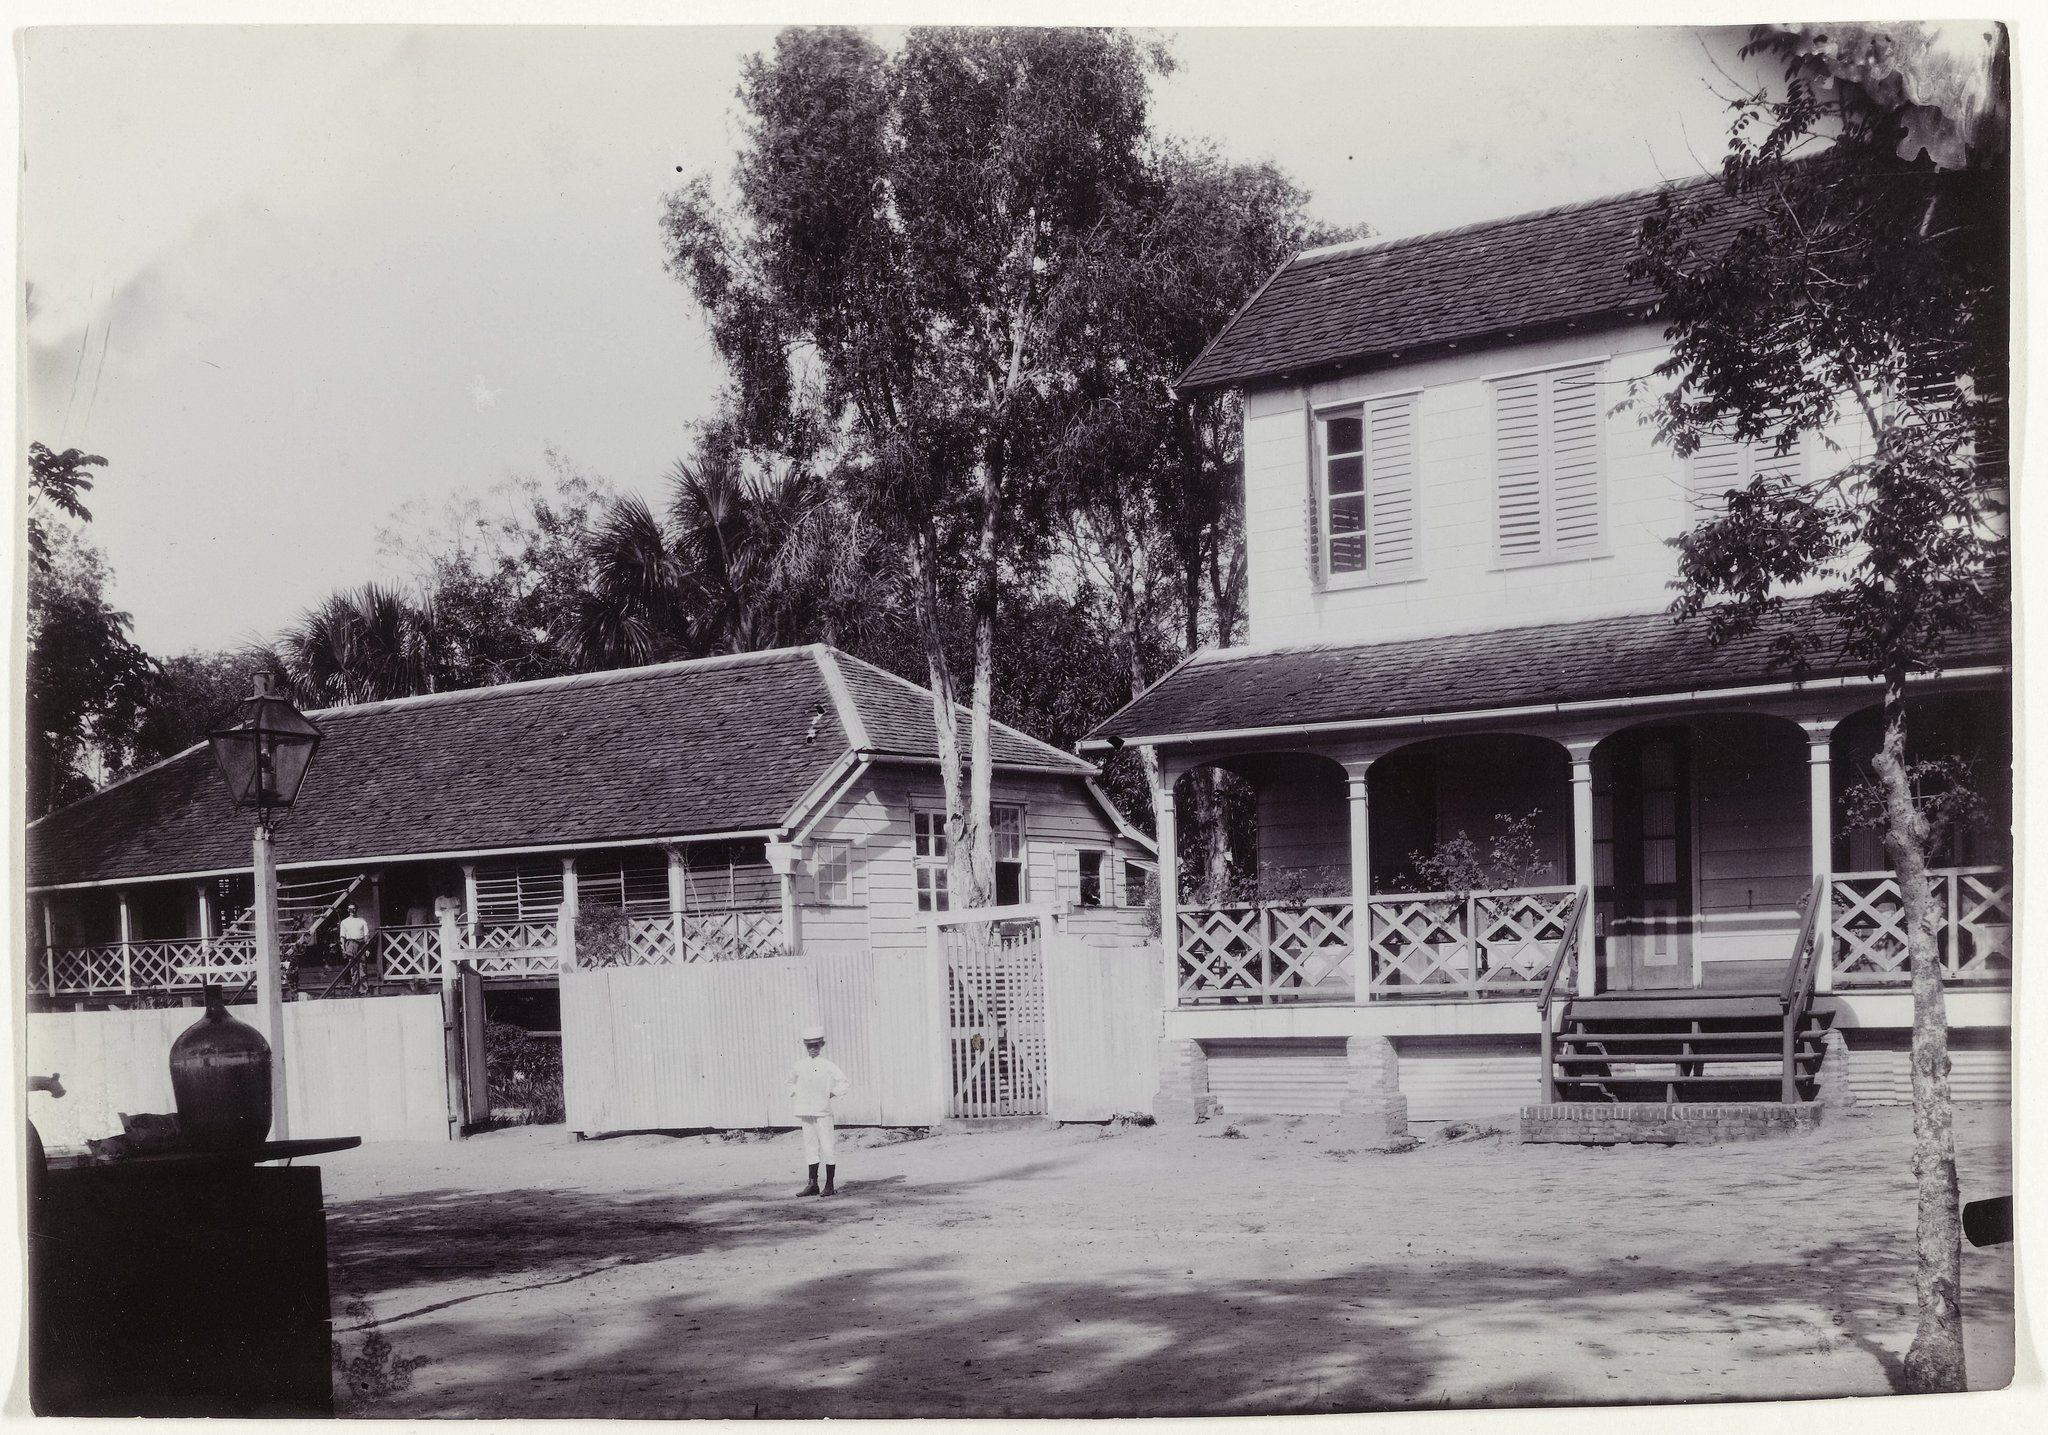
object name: photograph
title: Woning van de geneesheer Wesenhagen in Paramaribo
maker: jacob evert wesenhagen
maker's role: amateurfotograaf, arts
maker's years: 1862-1924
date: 1900-1910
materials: photographic support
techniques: photography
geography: suriname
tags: jacob evert wesenhagen, urban housing, suriname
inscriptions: annotation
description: De woning van de geneesheer Jacob Evert Wesenhagen in Paramaribo. Houten woning met bijgebouw, met op de voorgrond een jongen. Onderdeel van een groep objecten afkomstig van de familie Wesenhagen in Suriname.